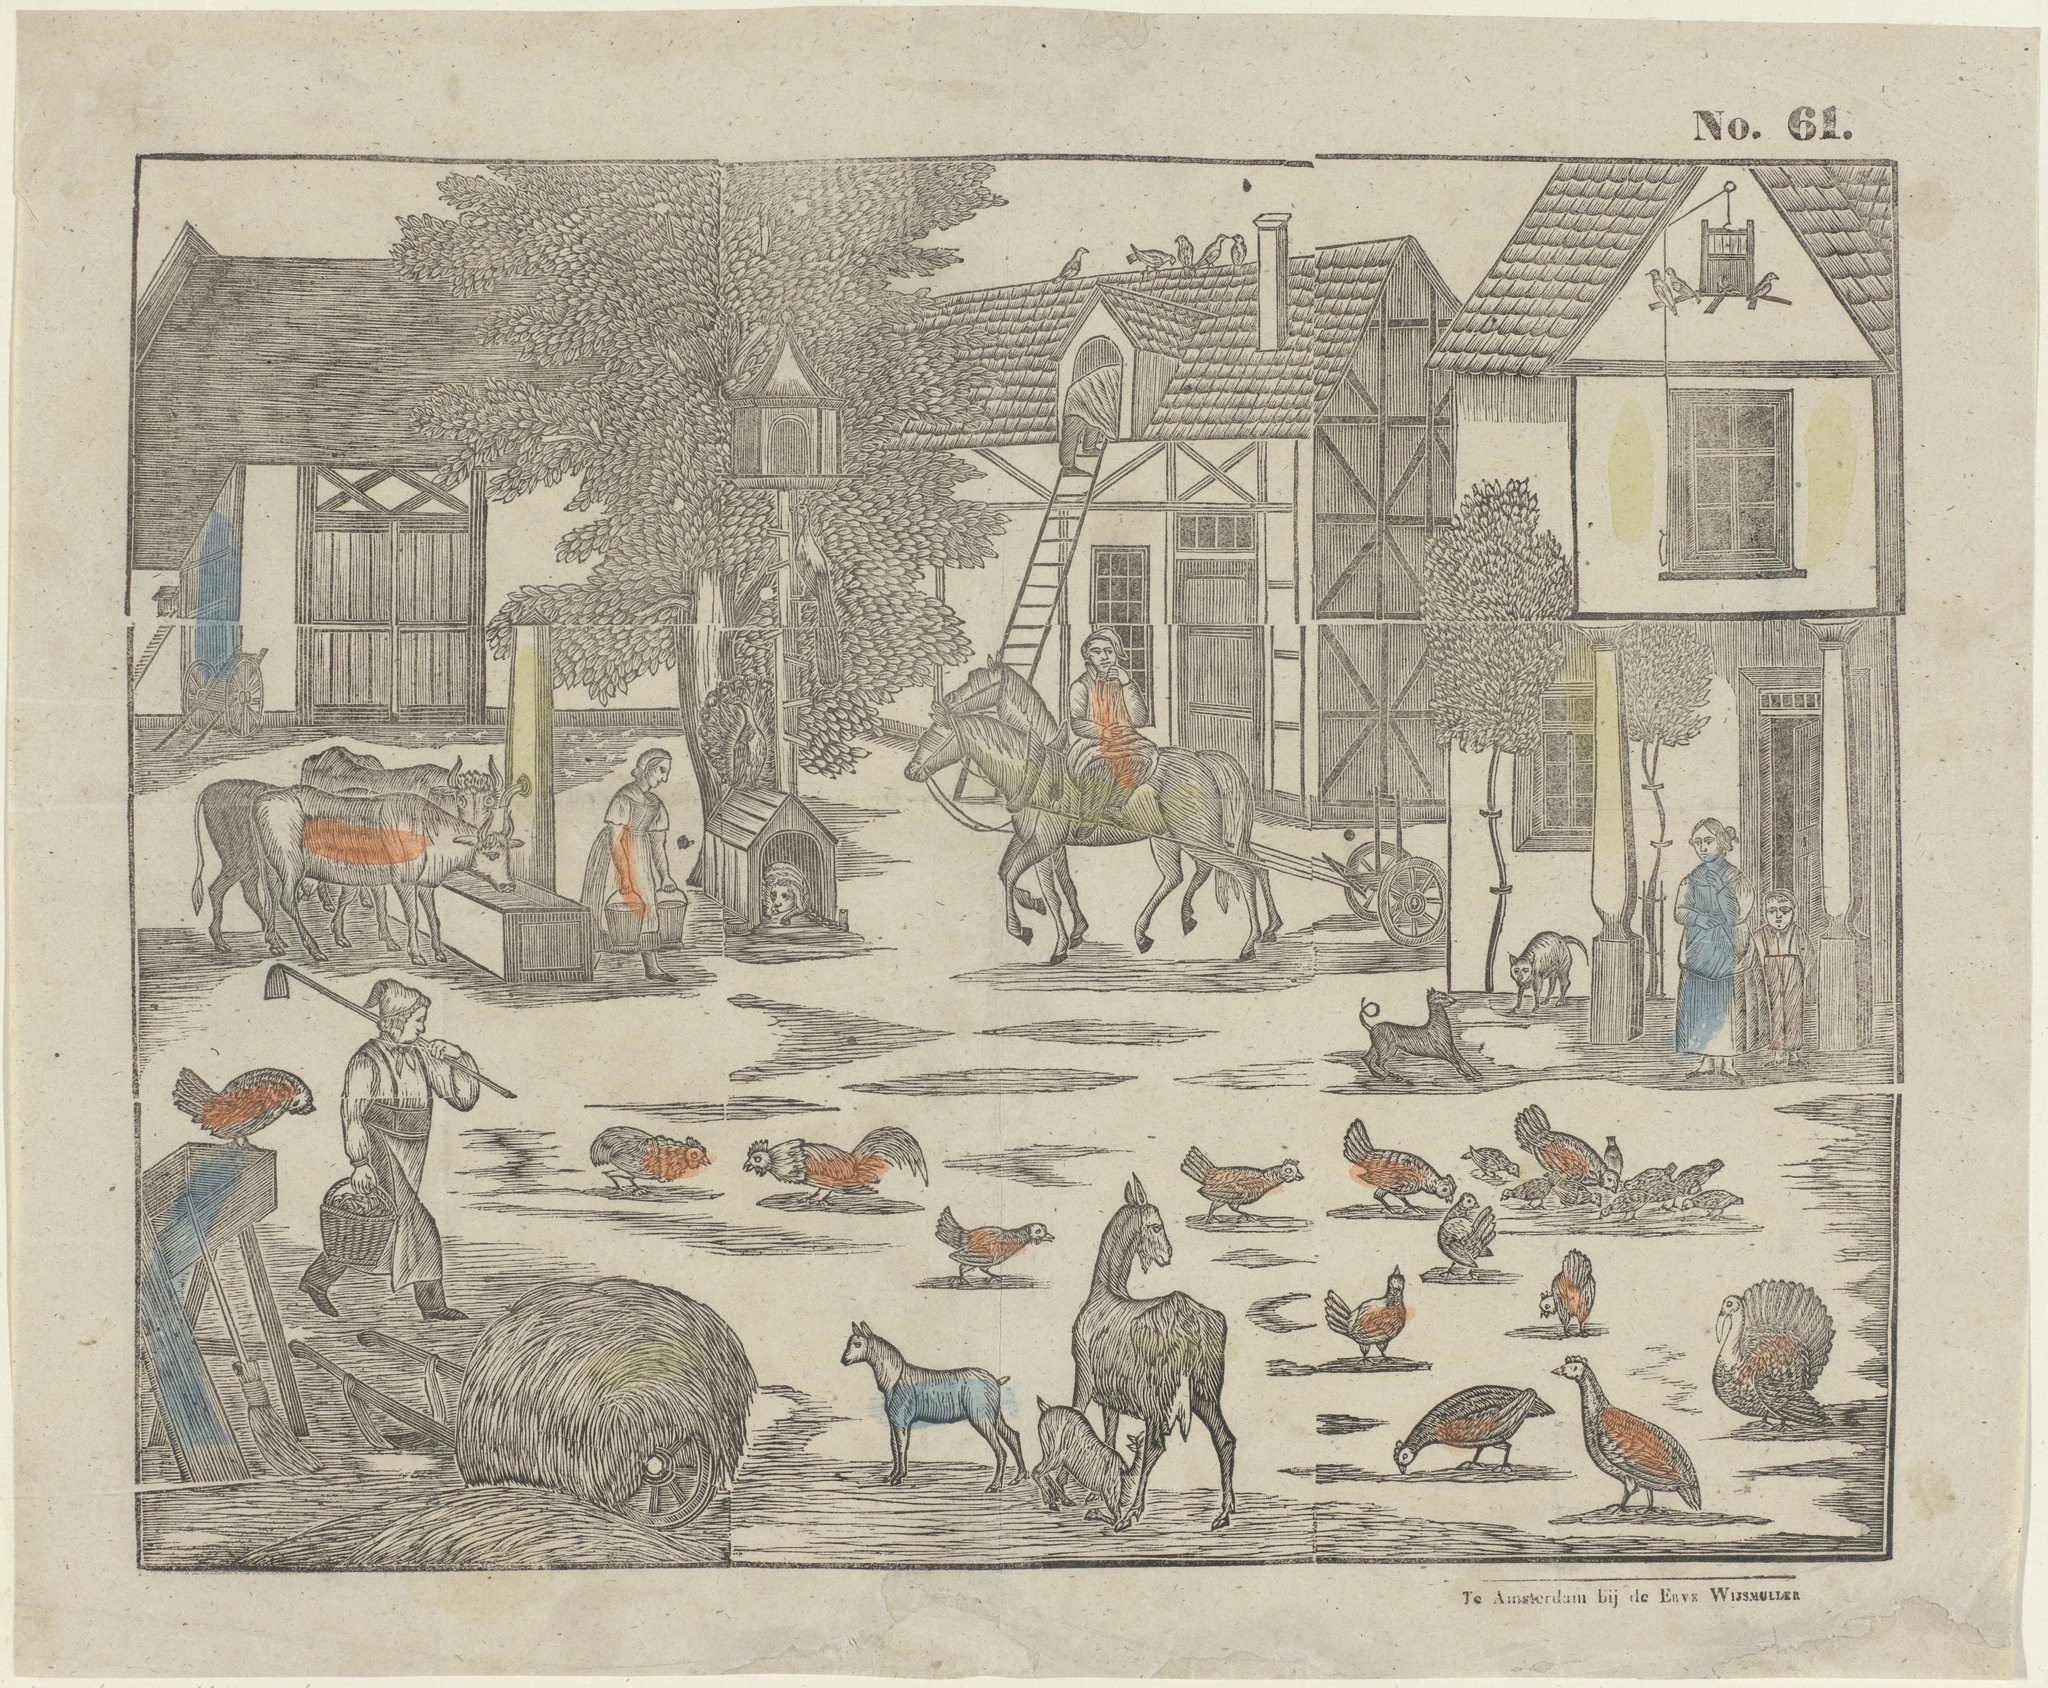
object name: print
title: Boerderij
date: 1832-1850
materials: paper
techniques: colour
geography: rotterdam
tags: cow, farmers, agricultural implements, horse, farm (building) - aa - civic architecture: inside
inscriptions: collector's mark: Lugt 2760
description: Een boerderij met boeren, boerinnen en dieren, waaronder koeien, paarden, geiten en kippen. Genummerd rechtsboven: No. 61.